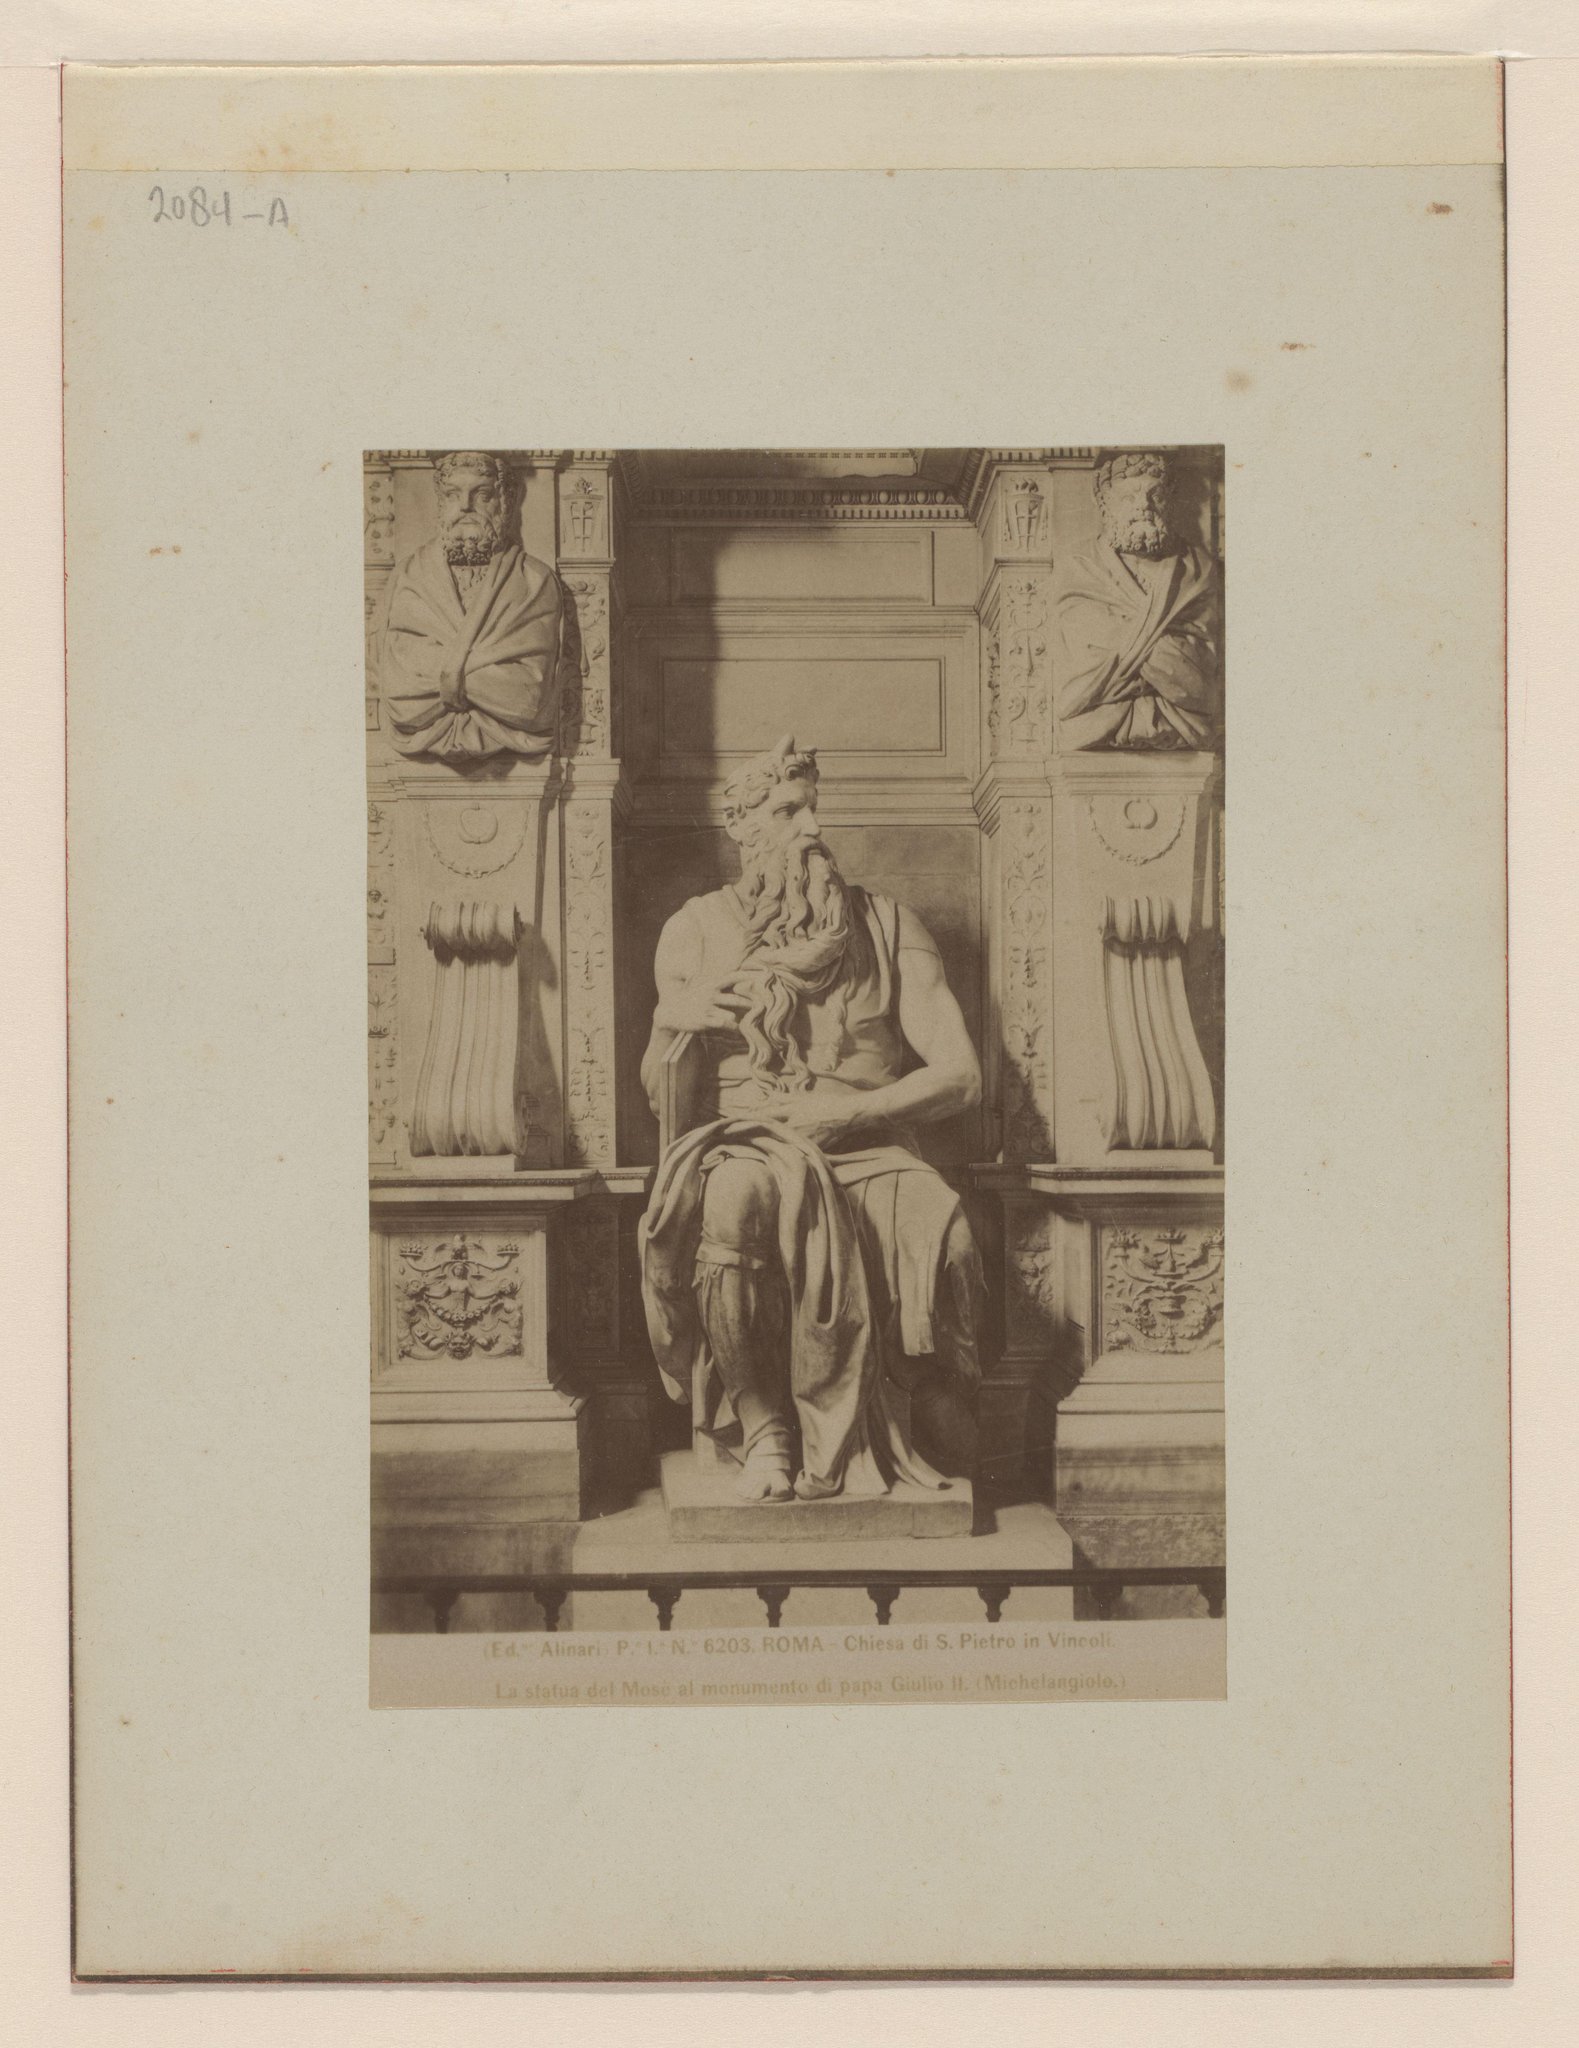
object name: photograph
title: Roma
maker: michelangelo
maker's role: draughtsman, painter, sculptor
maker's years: 1475-1564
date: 1857-1900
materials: cardboard, paper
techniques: albumen print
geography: rome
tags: piece of sculpture, reproduction of a piece of sculpture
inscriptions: number: ‘Pe.Ia.No. 6203.’